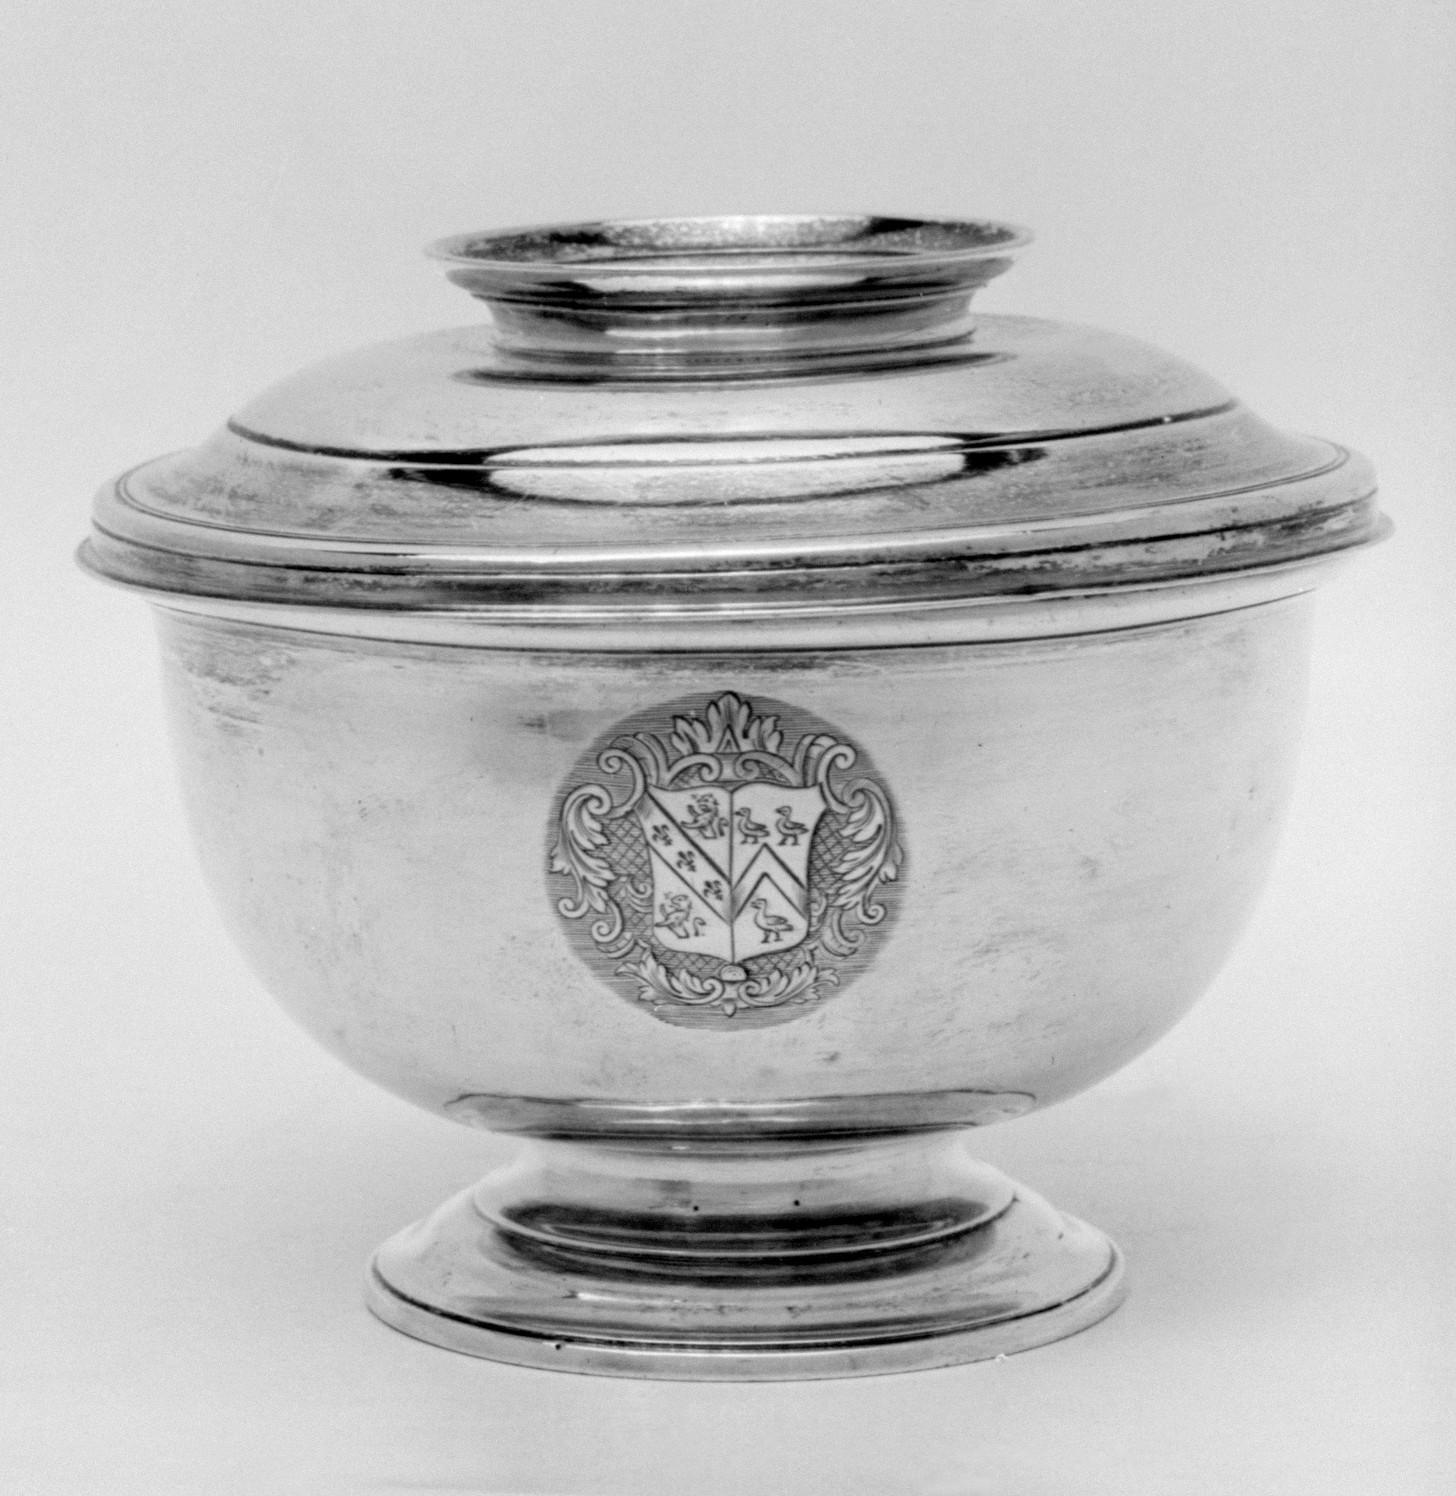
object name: bowl with cover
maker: john gamon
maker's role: maker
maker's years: 1727-1740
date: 1728-1729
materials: silver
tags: birds,coat of arms